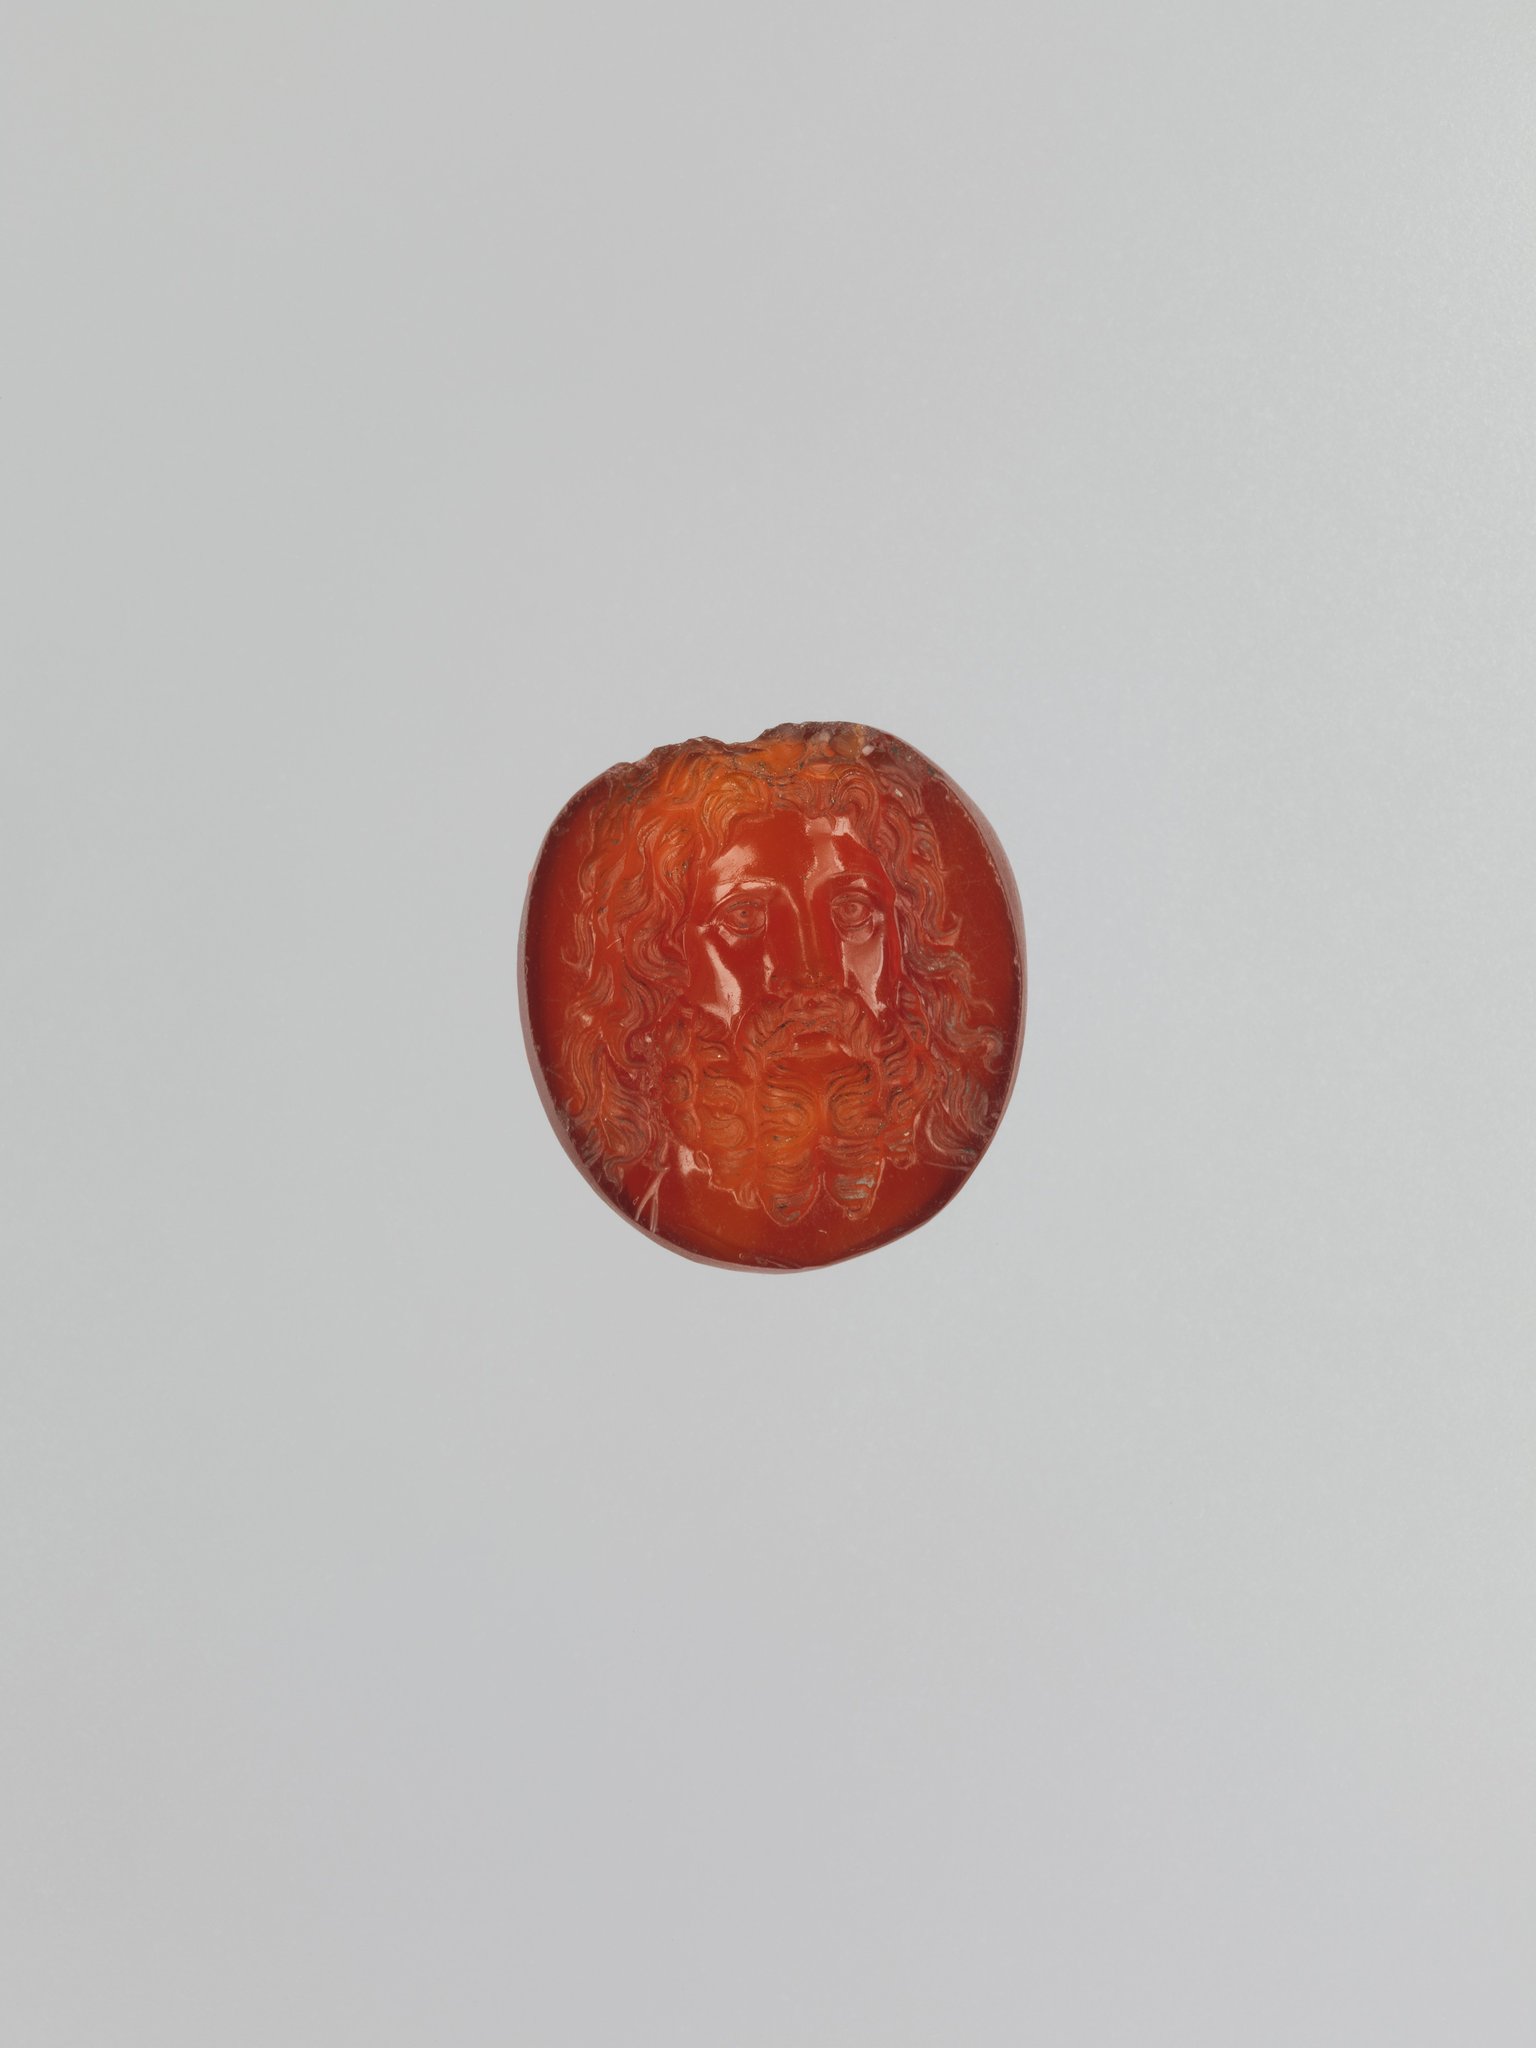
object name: intaglio, serapis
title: Intaglio with head of Serapis (?)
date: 332-330 BCE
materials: gemstone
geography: egypt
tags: men